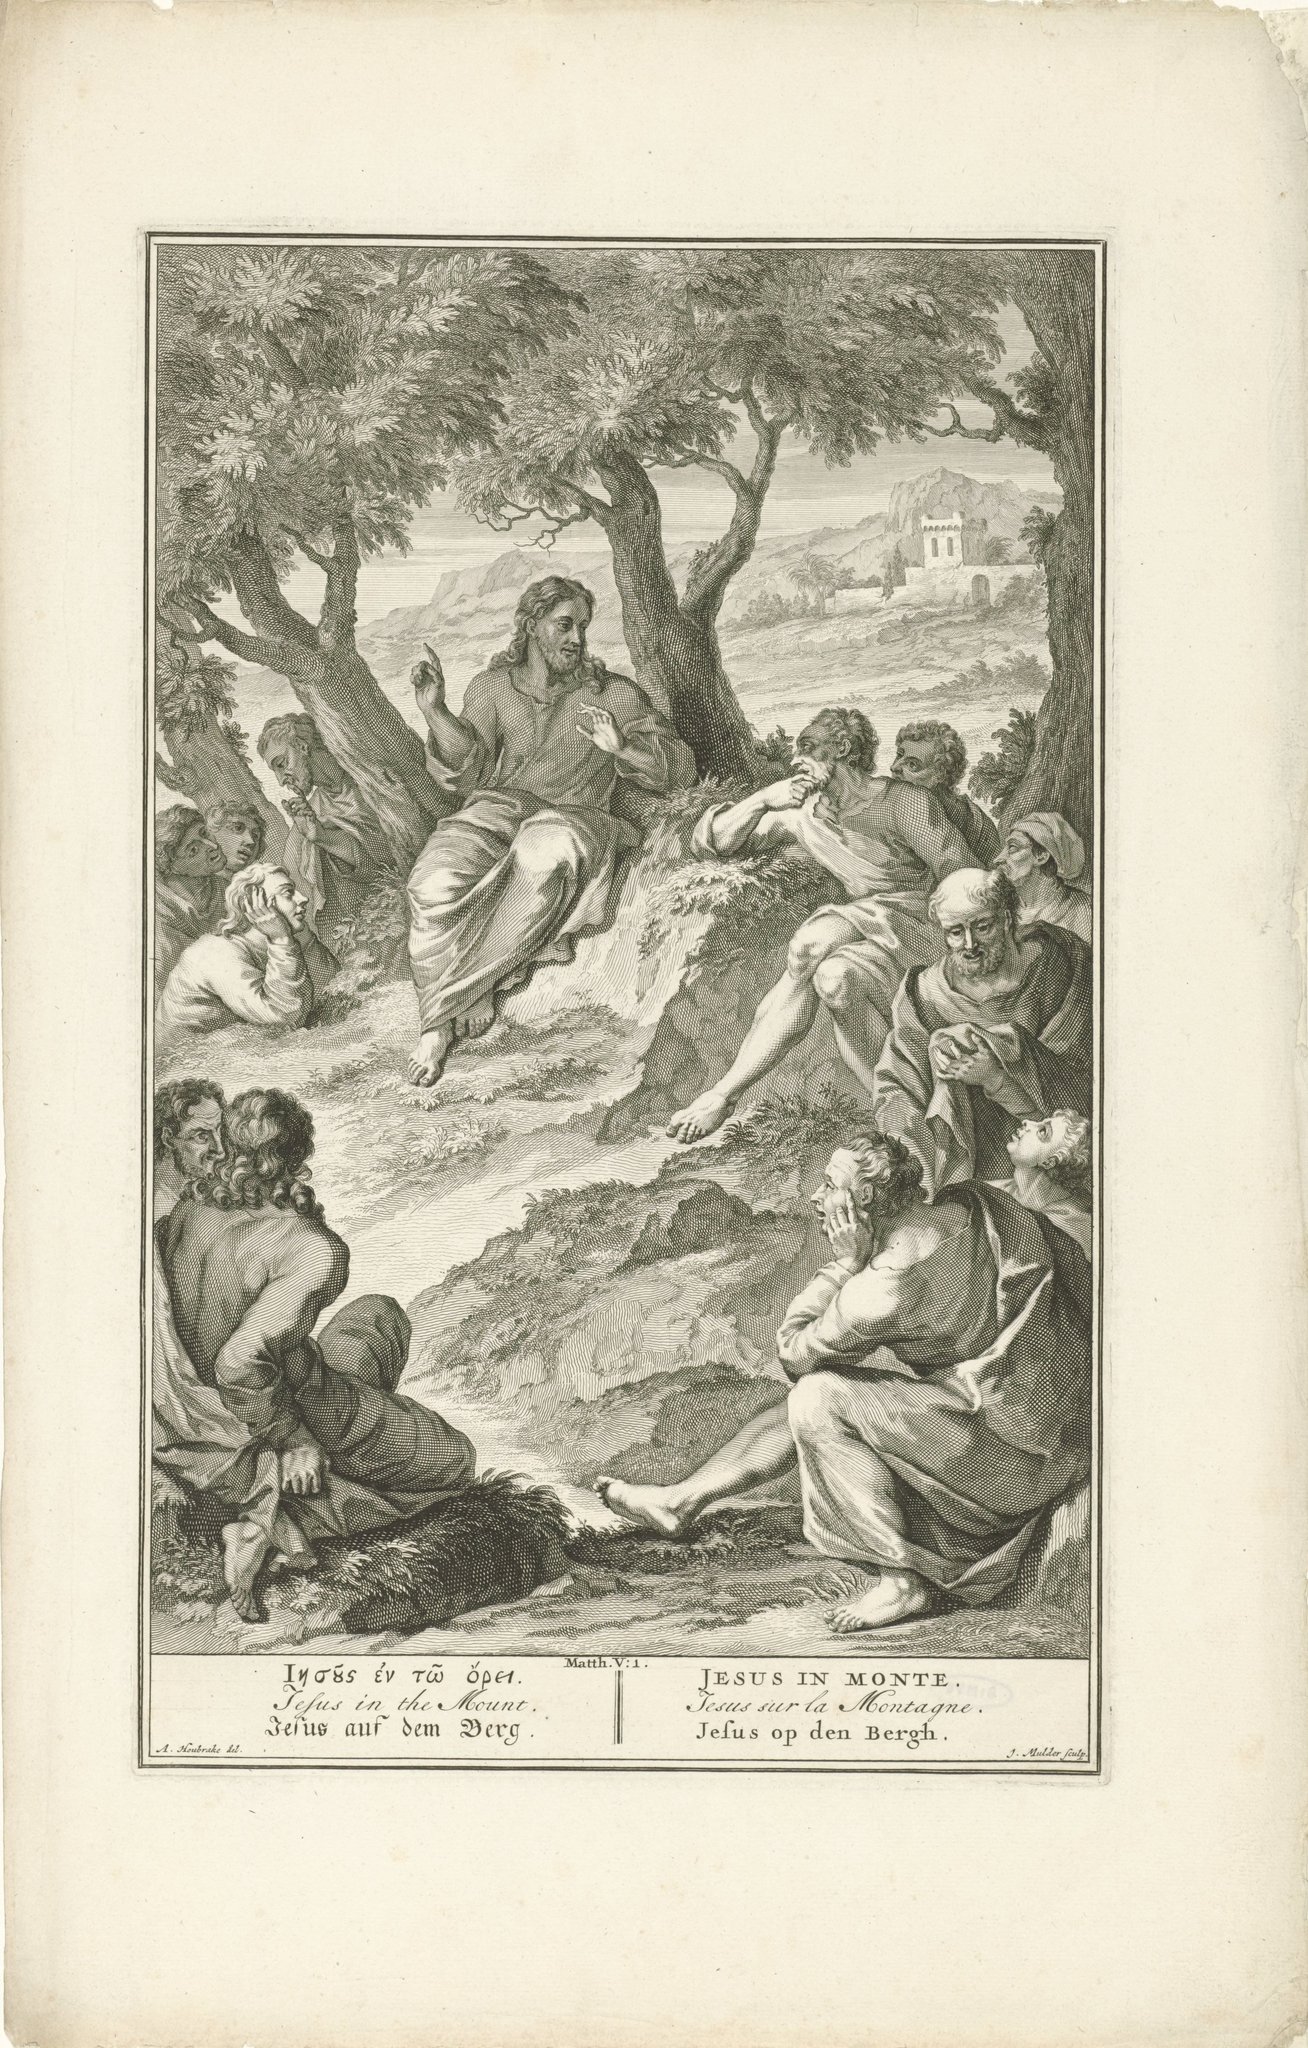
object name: book illustration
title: Bergrede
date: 1720-1728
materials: paper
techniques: engraving, etching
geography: amsterdam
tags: christ's sermon on the mount (matthew 5-7)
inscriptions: collector's mark: Lugt 2228, inscription: ‘Utrechts Fundatie huijs’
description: Prent gemaakt voor: Figures de la Bible. Amsterdam, Bernard Picart, 1720. Prent ook gebruikt in: Taferelen der voornaamste geschiedenissen van het Oude en Nieuwe Testament (...) door de vermaarde kunstenaars Hoet, Houbraken, en Picart getekent (...) en met beschrijvingen uitgebreid. Den Haag: Pieter de Hondt, 1728.